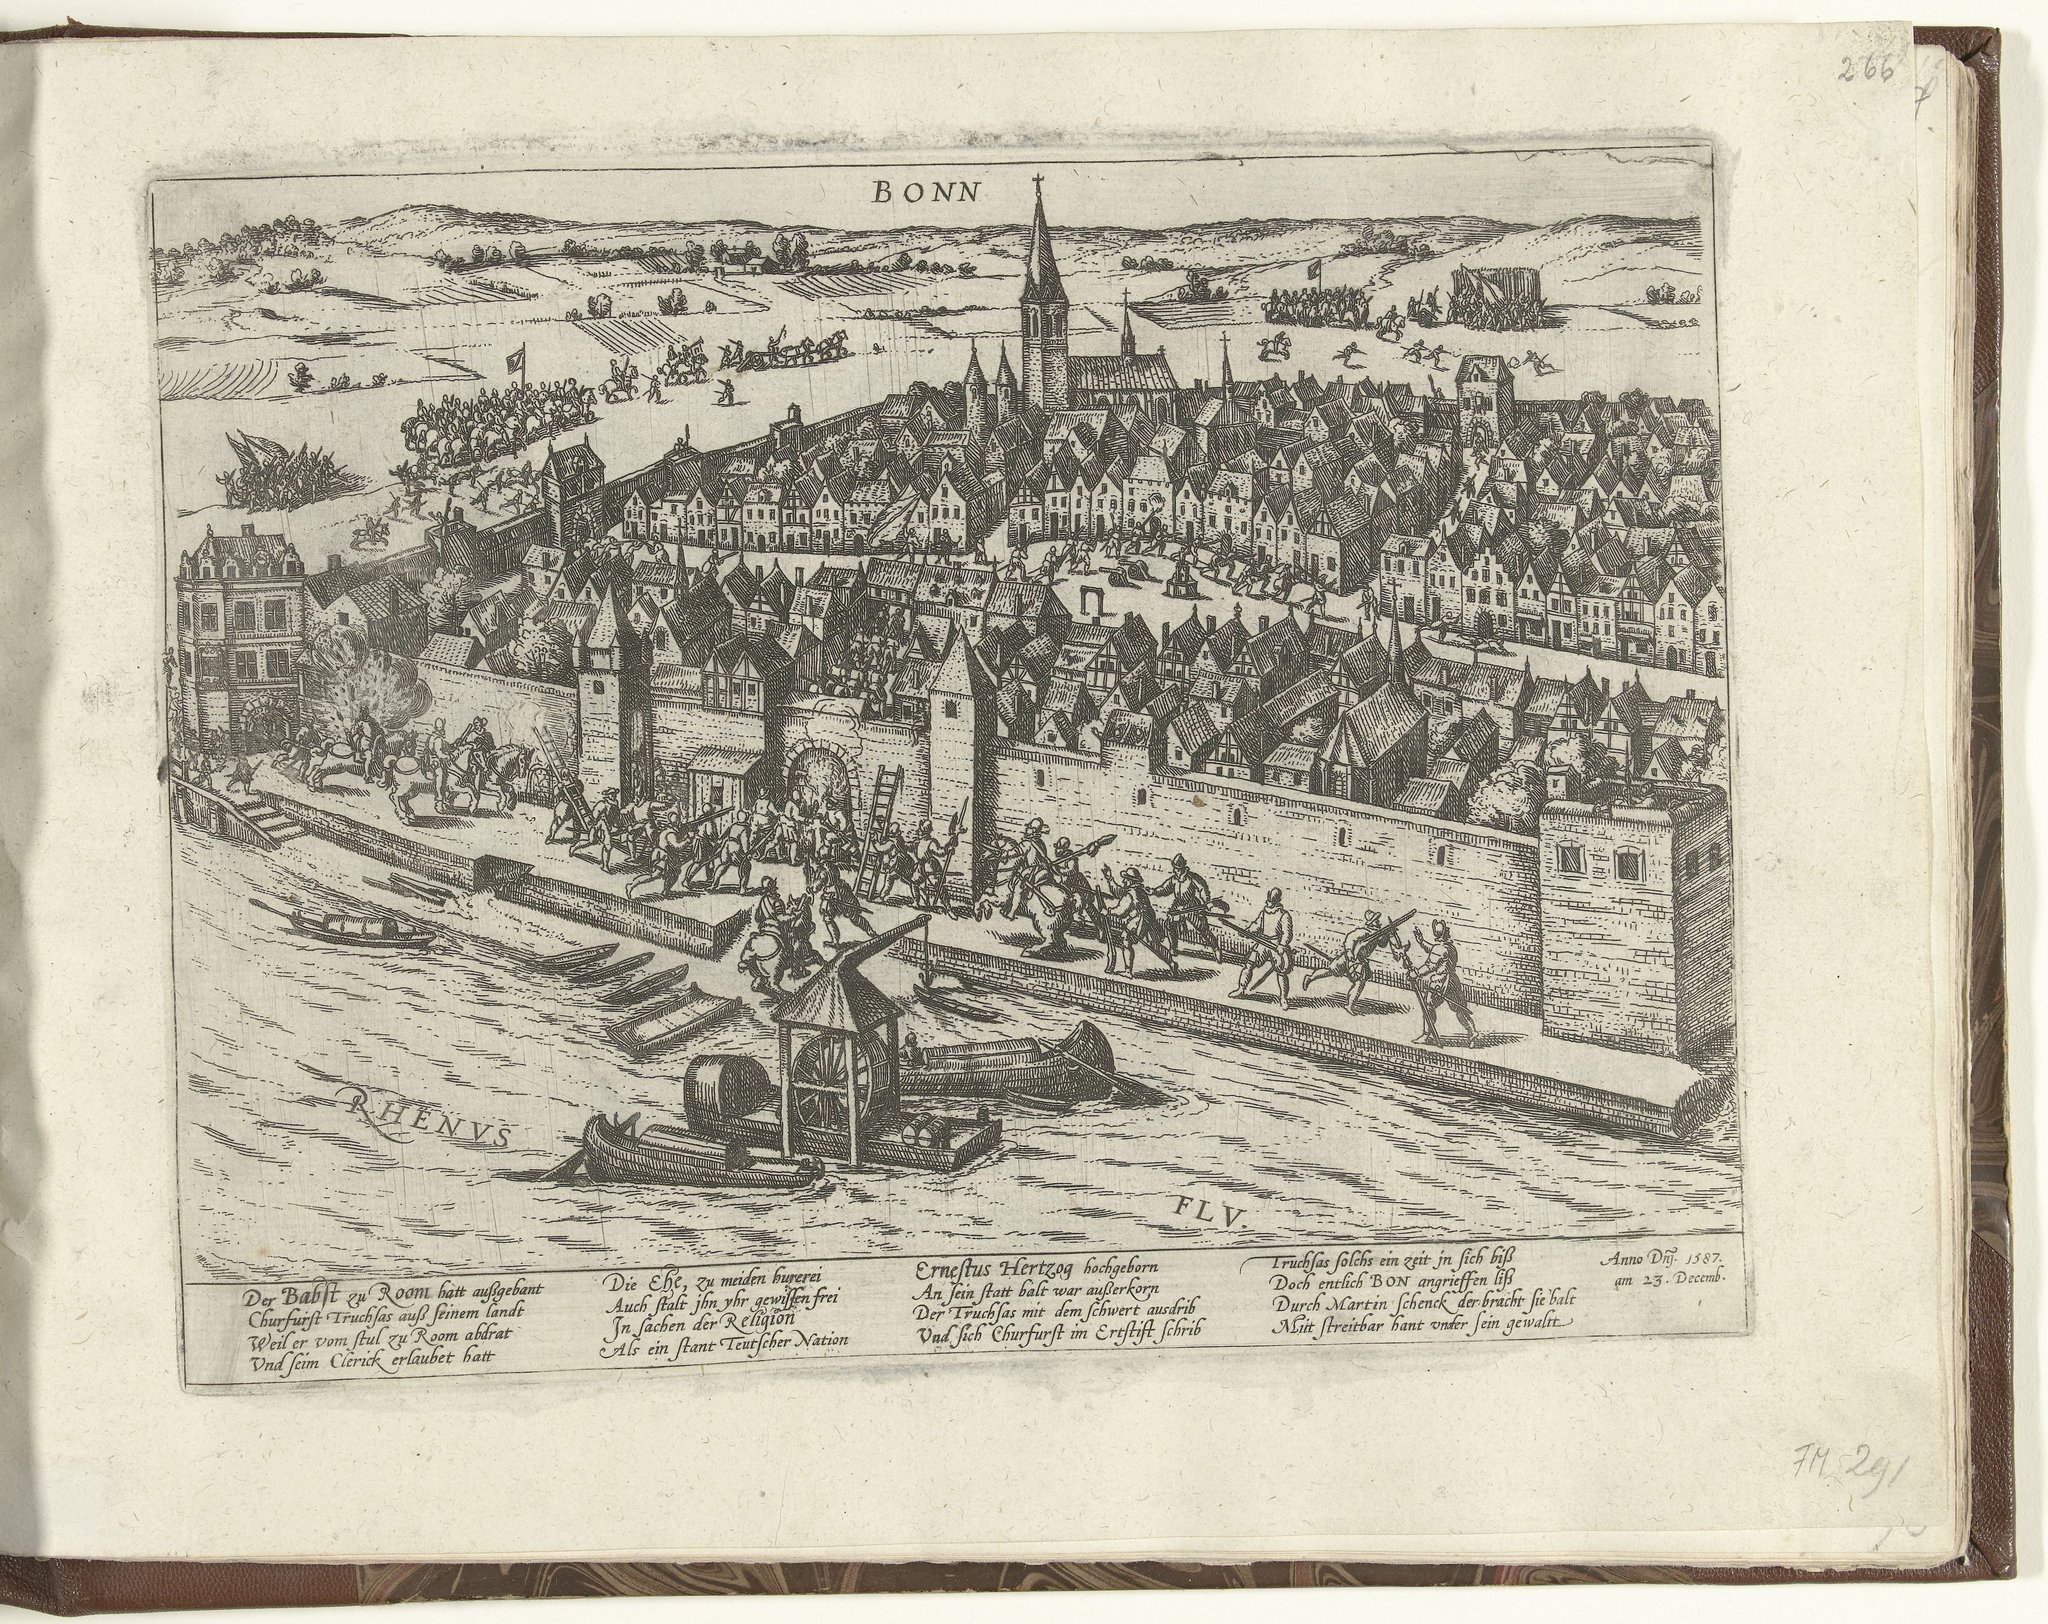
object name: print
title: Bonn door Schenck voor Truchsess gewonnen, 1587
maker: frans hogenberg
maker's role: print maker, publisher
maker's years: 1538-1590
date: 1587-1589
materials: paper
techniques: etching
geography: cologne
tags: nijmegen, capture of city (after the siege)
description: Bonn door Schenck voor Truchsess gewonnen, 23 december 1587. Episode uit de Keulse Oorlog. Met onderschrift van 16 regels in het Duits. Ongenummerd.